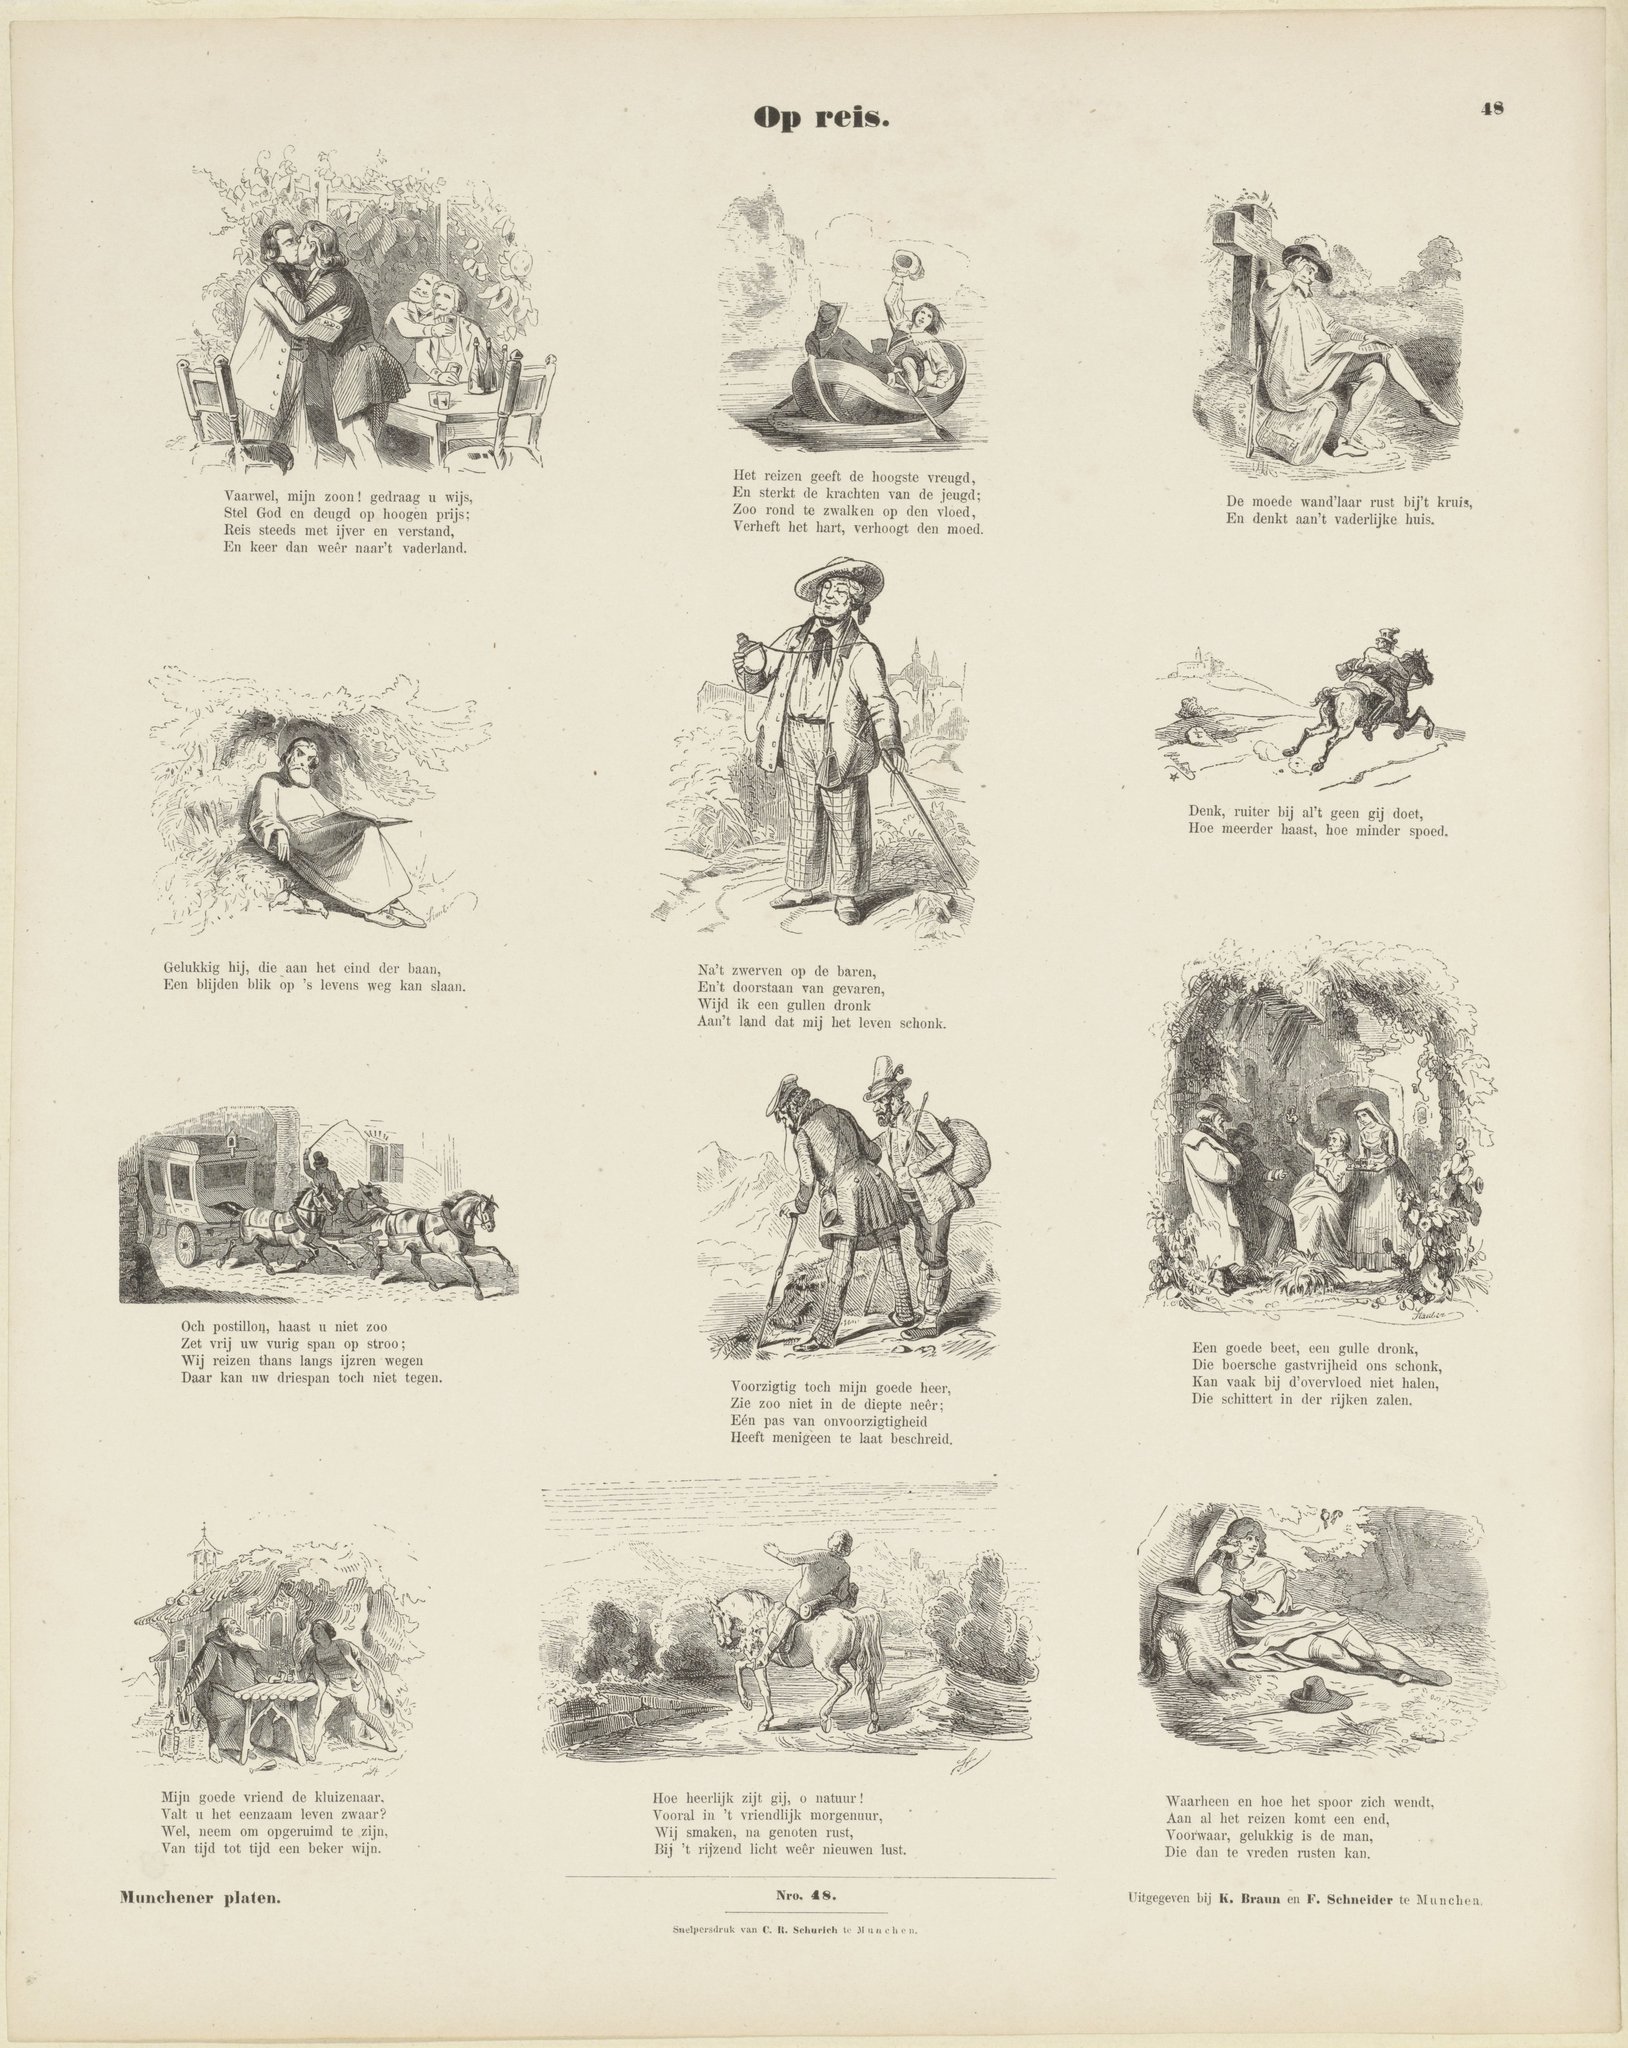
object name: print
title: Munchener platen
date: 1843-1920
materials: paper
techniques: letterpress printing, engraving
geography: germany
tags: travelling; tourism, departure ~ travelling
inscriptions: collector's mark: Lugt 2760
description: Blad met 12 voorstellingen van mensen die op reis zijn. Onder elke afbeelding een onderschrift. Genummerd midden onder: Nro. 48. Genummerd rechtsboven: 48.